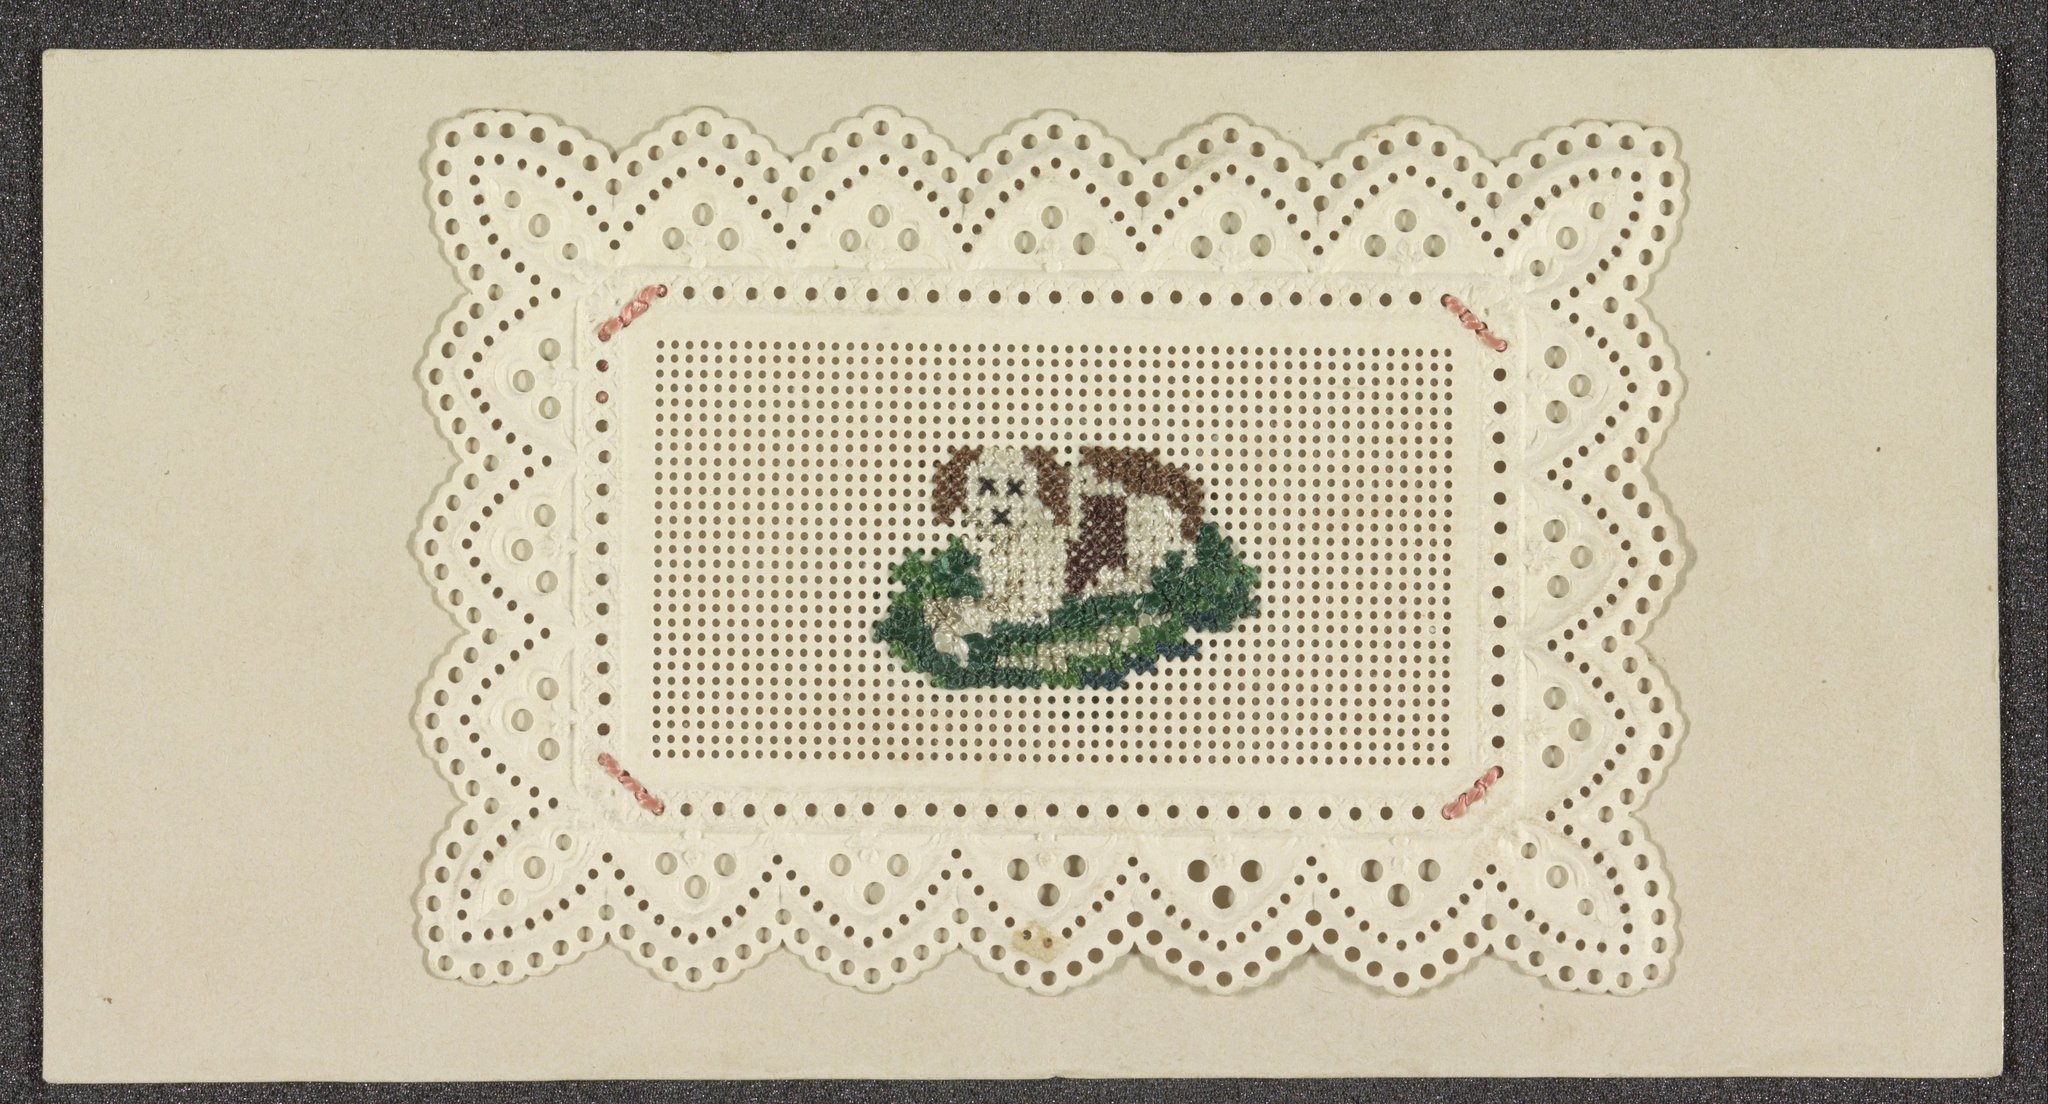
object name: album leaf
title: Liggende hond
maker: h.p.m. de bel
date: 1849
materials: cardboard, paper, yarns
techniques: embroidered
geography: rotterdam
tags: 'album amicorum', 'stammbuch', dog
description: Liggende hond. Bijdrage aan een Album Amicorum.